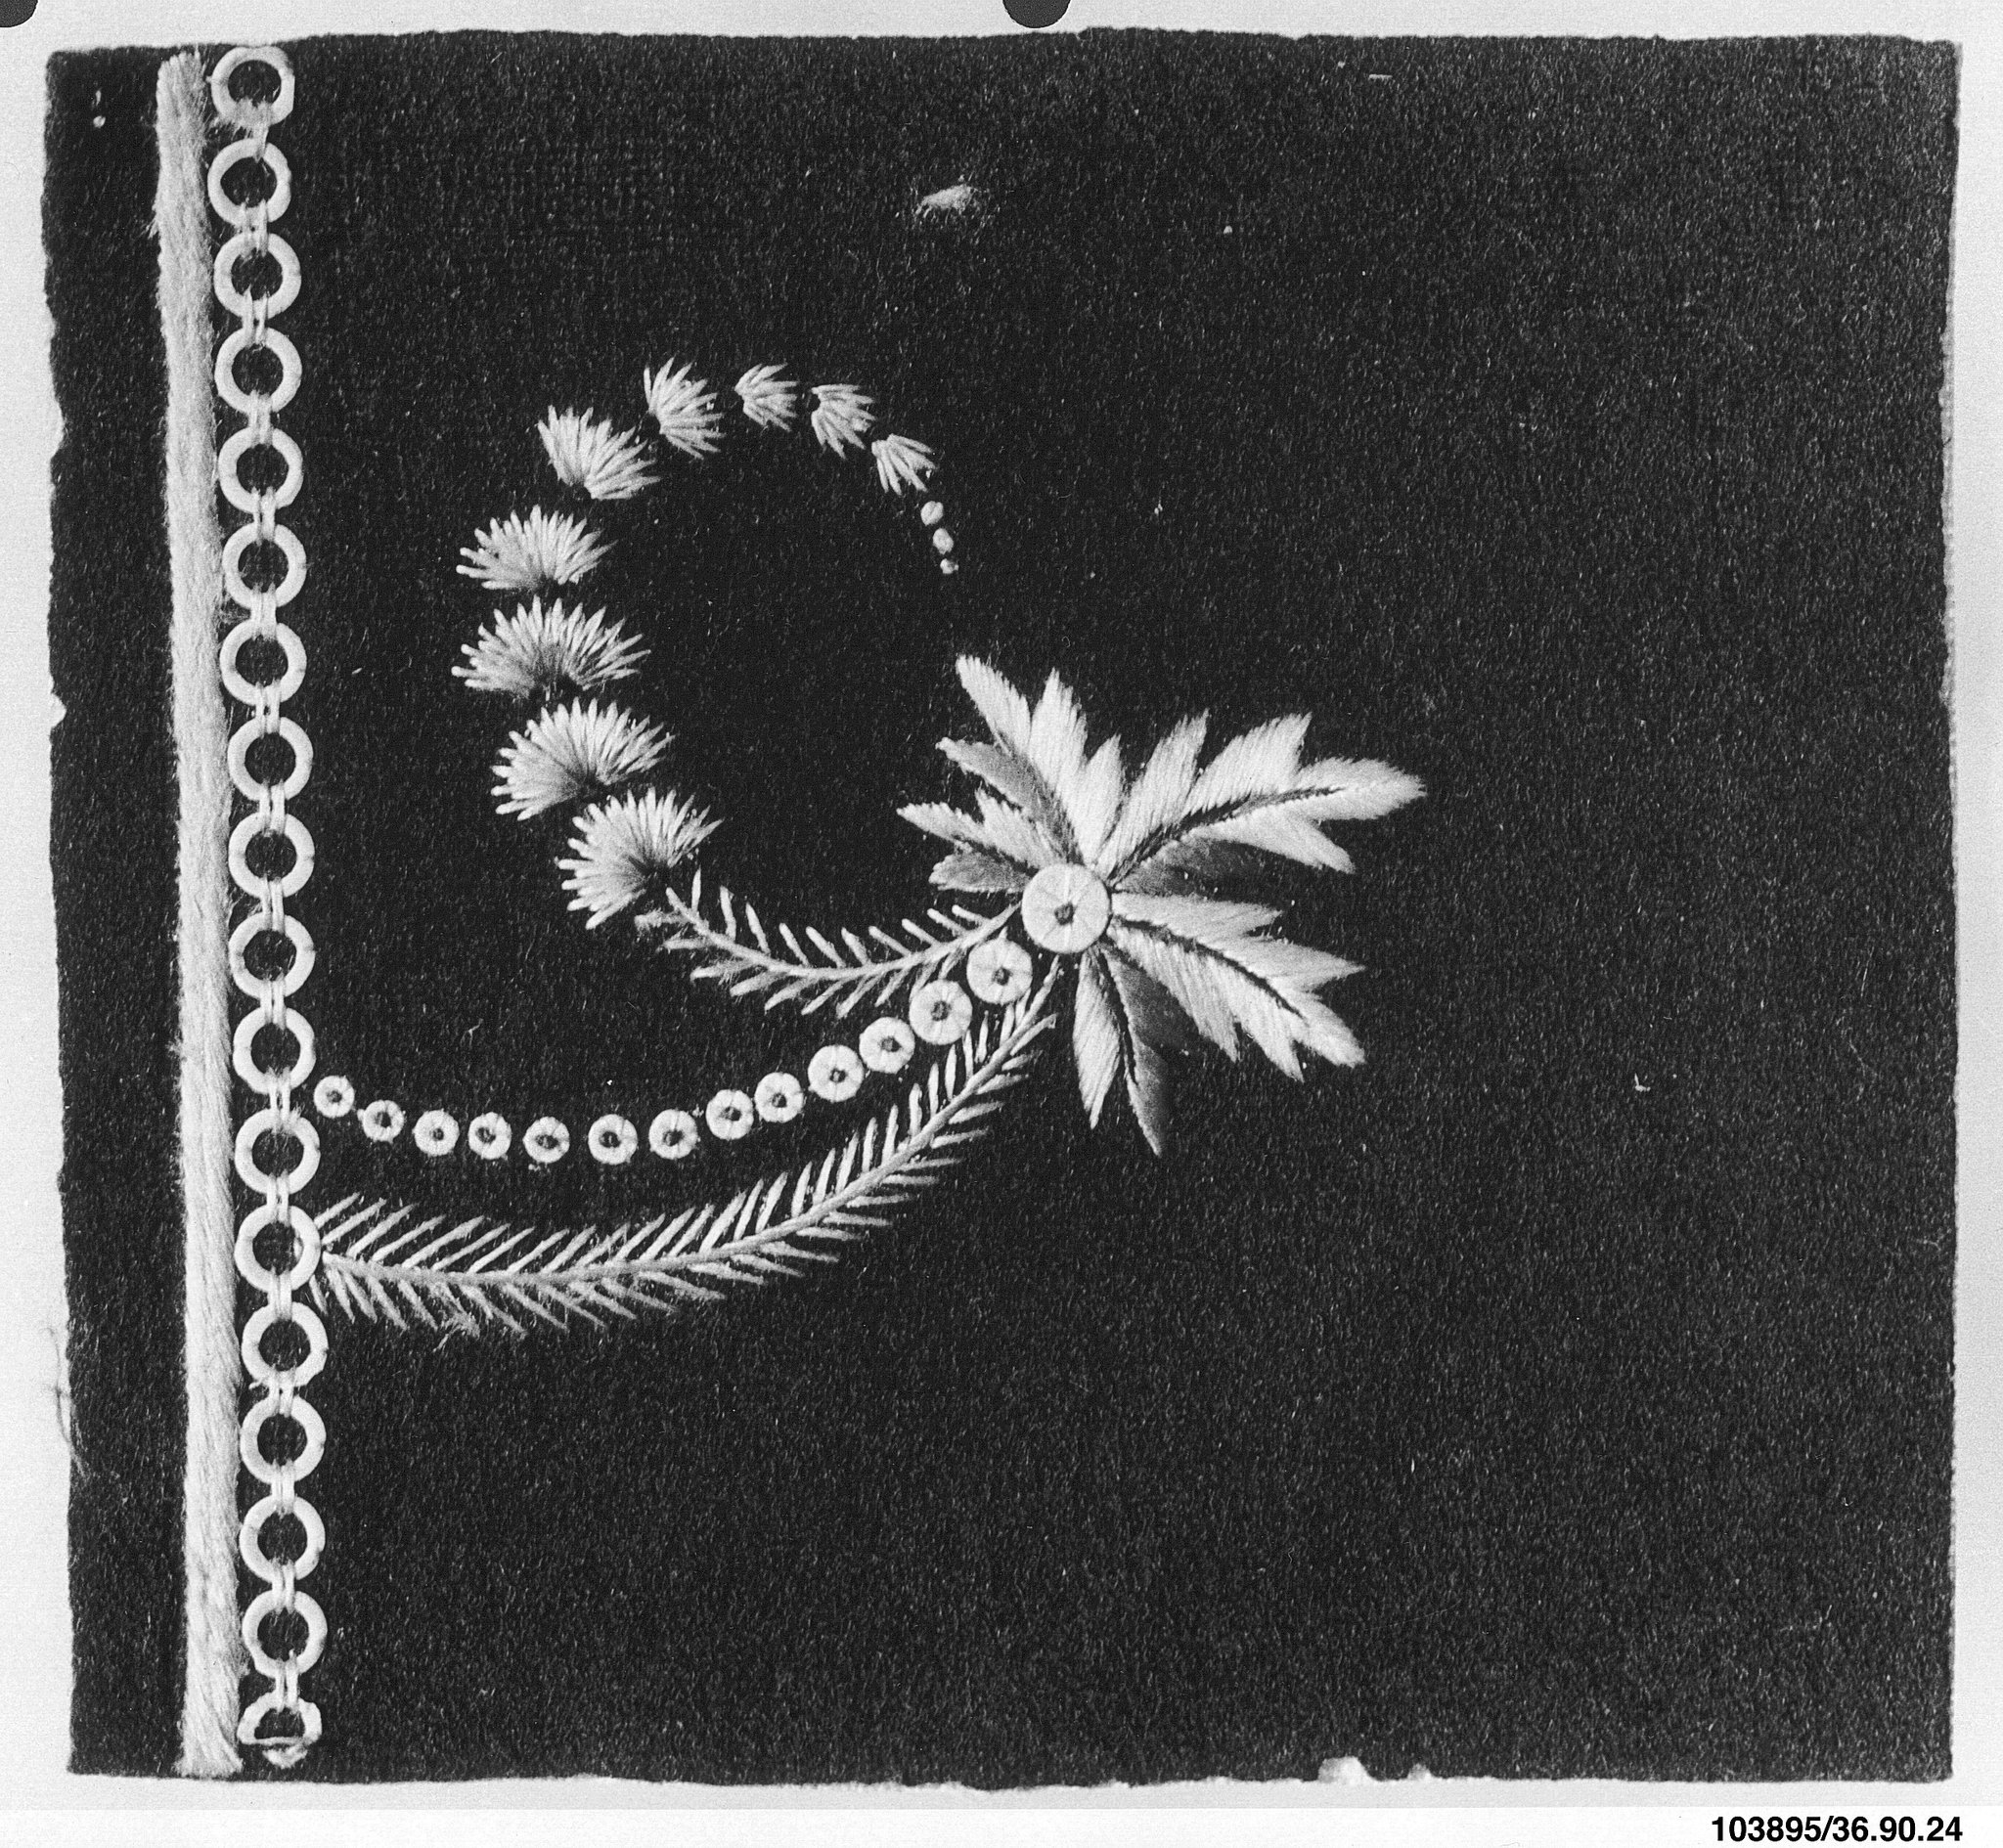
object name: sample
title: Embroidery sample for a man’s suit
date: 1785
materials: cardboard, thread, wool